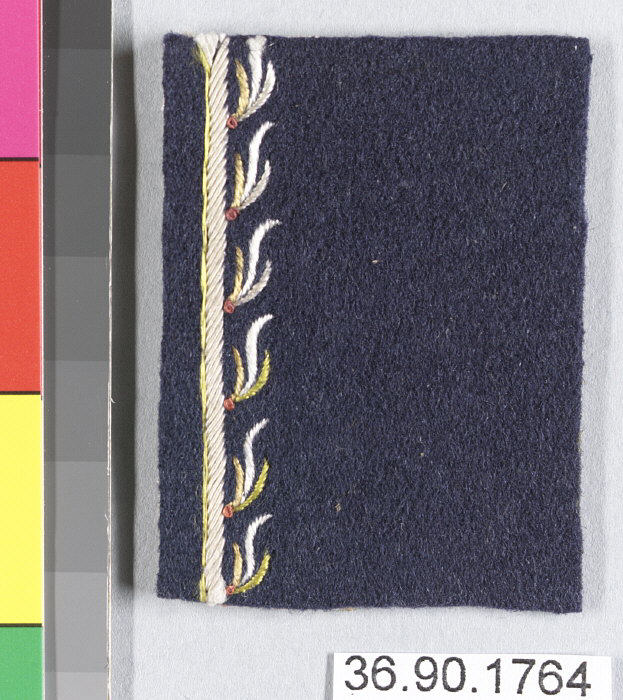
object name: sample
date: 1801-1833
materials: felt, silk